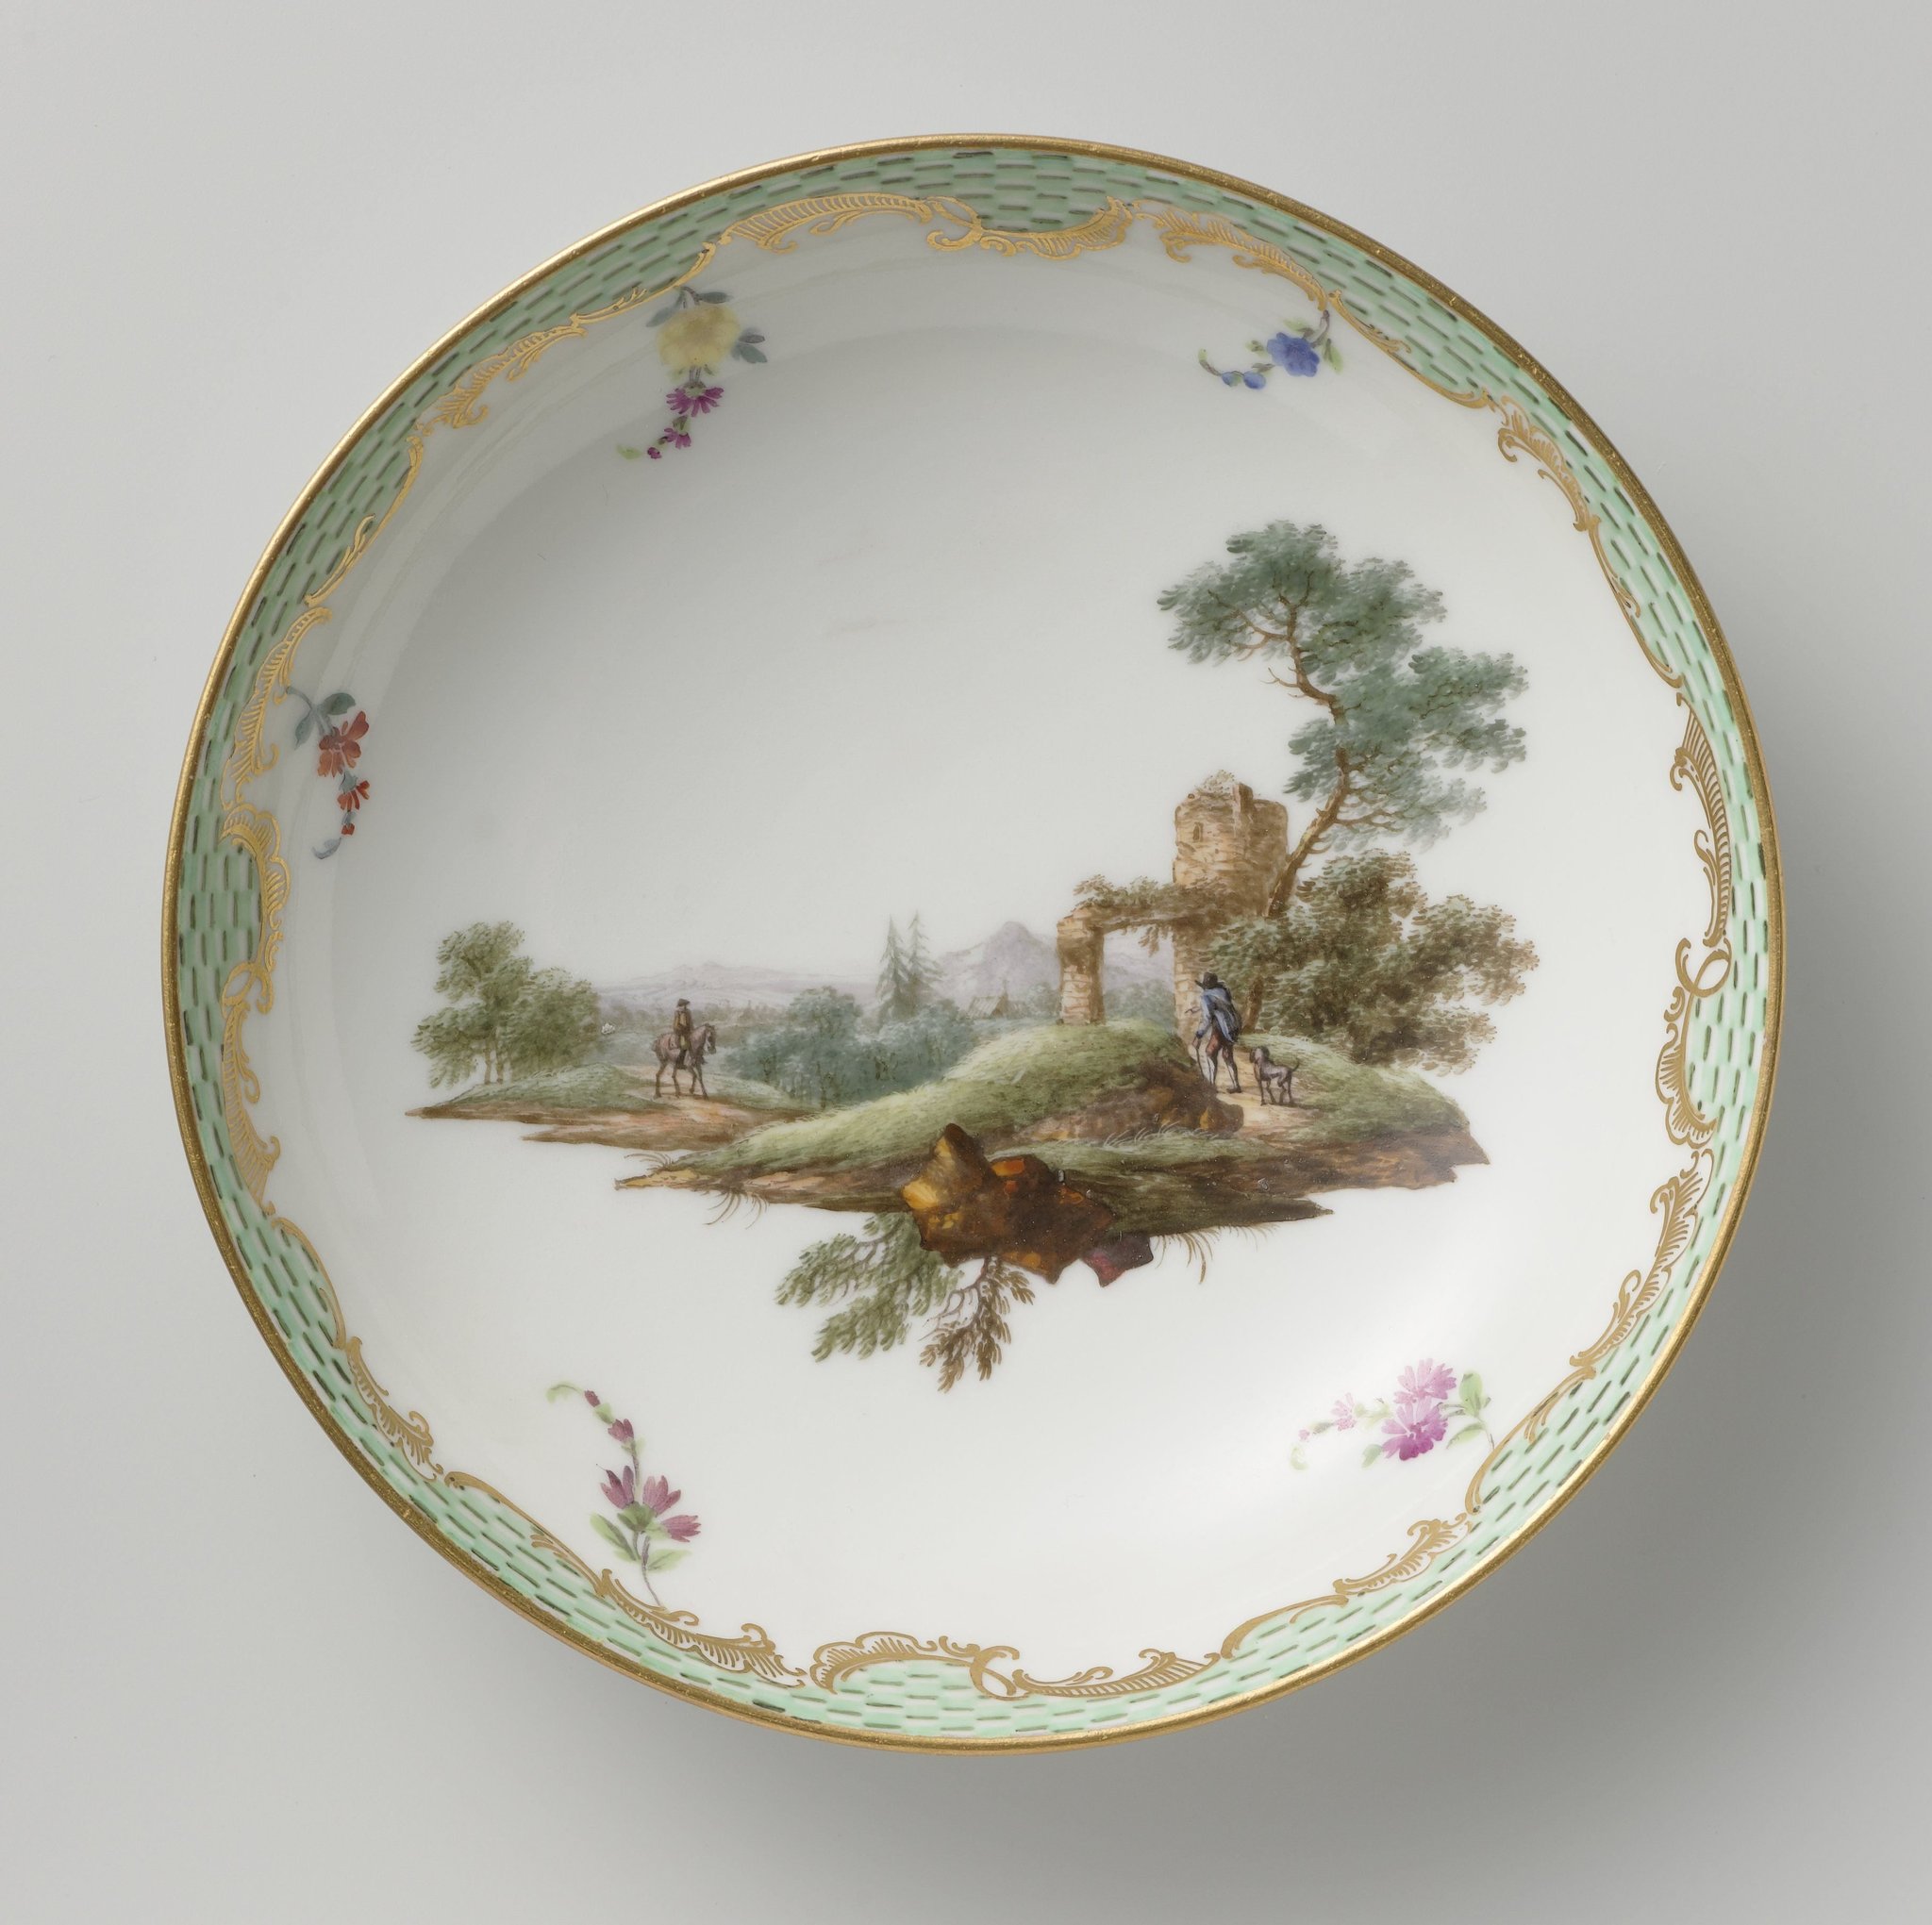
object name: eating drinking utensil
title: Schotel, veelkleurig beschilderd met een landschap met figuren.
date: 1777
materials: porcelain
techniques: painted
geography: meissen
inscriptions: mold mark: ‘5’, factory mark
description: Ronde schotel van beschilderd porselein. De schotel is beschilderd met landschappen waarin figuren en langs de rand een brede strook groen vlechtwerk. De schotel is gemerkt.